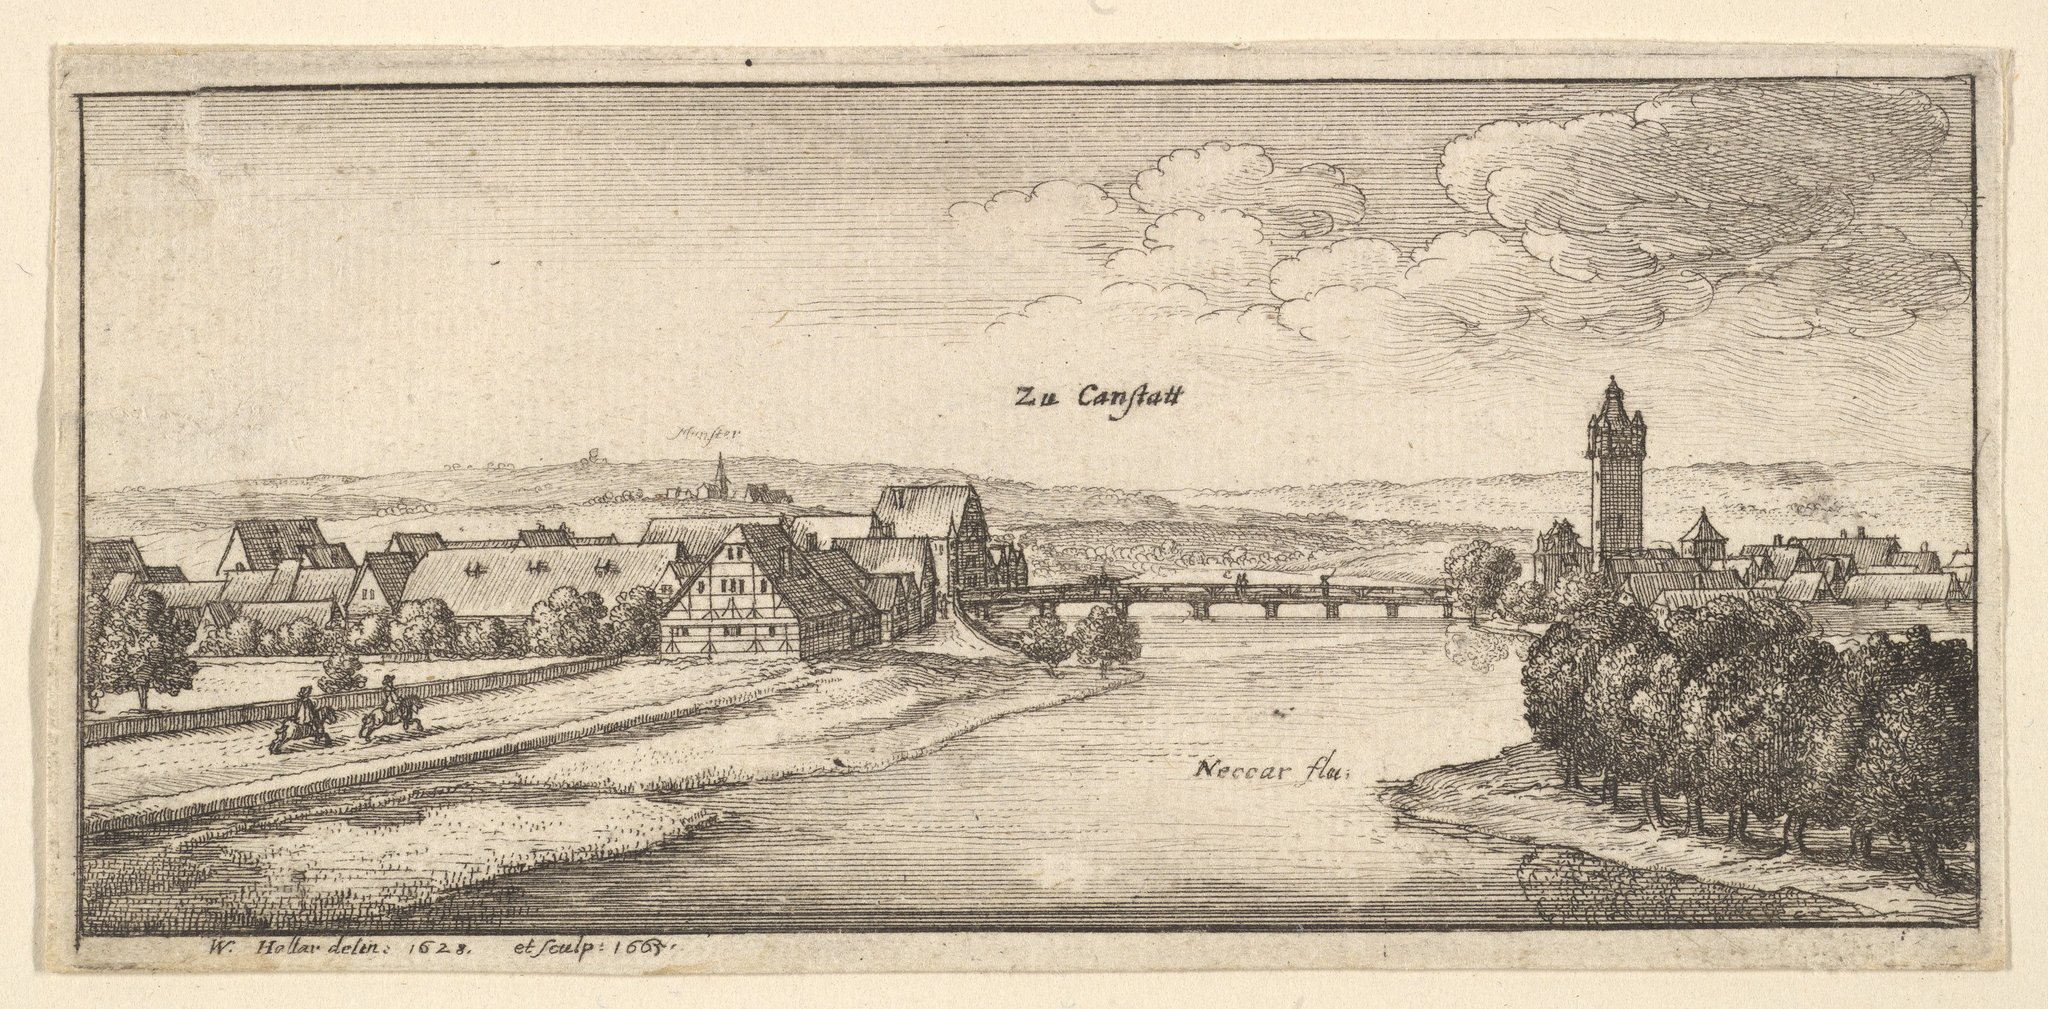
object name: print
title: Cannstadt, from "German Views"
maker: wenceslaus hollar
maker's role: artist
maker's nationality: bohemian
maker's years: 1607-1677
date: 1665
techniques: etching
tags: bridges,rivers